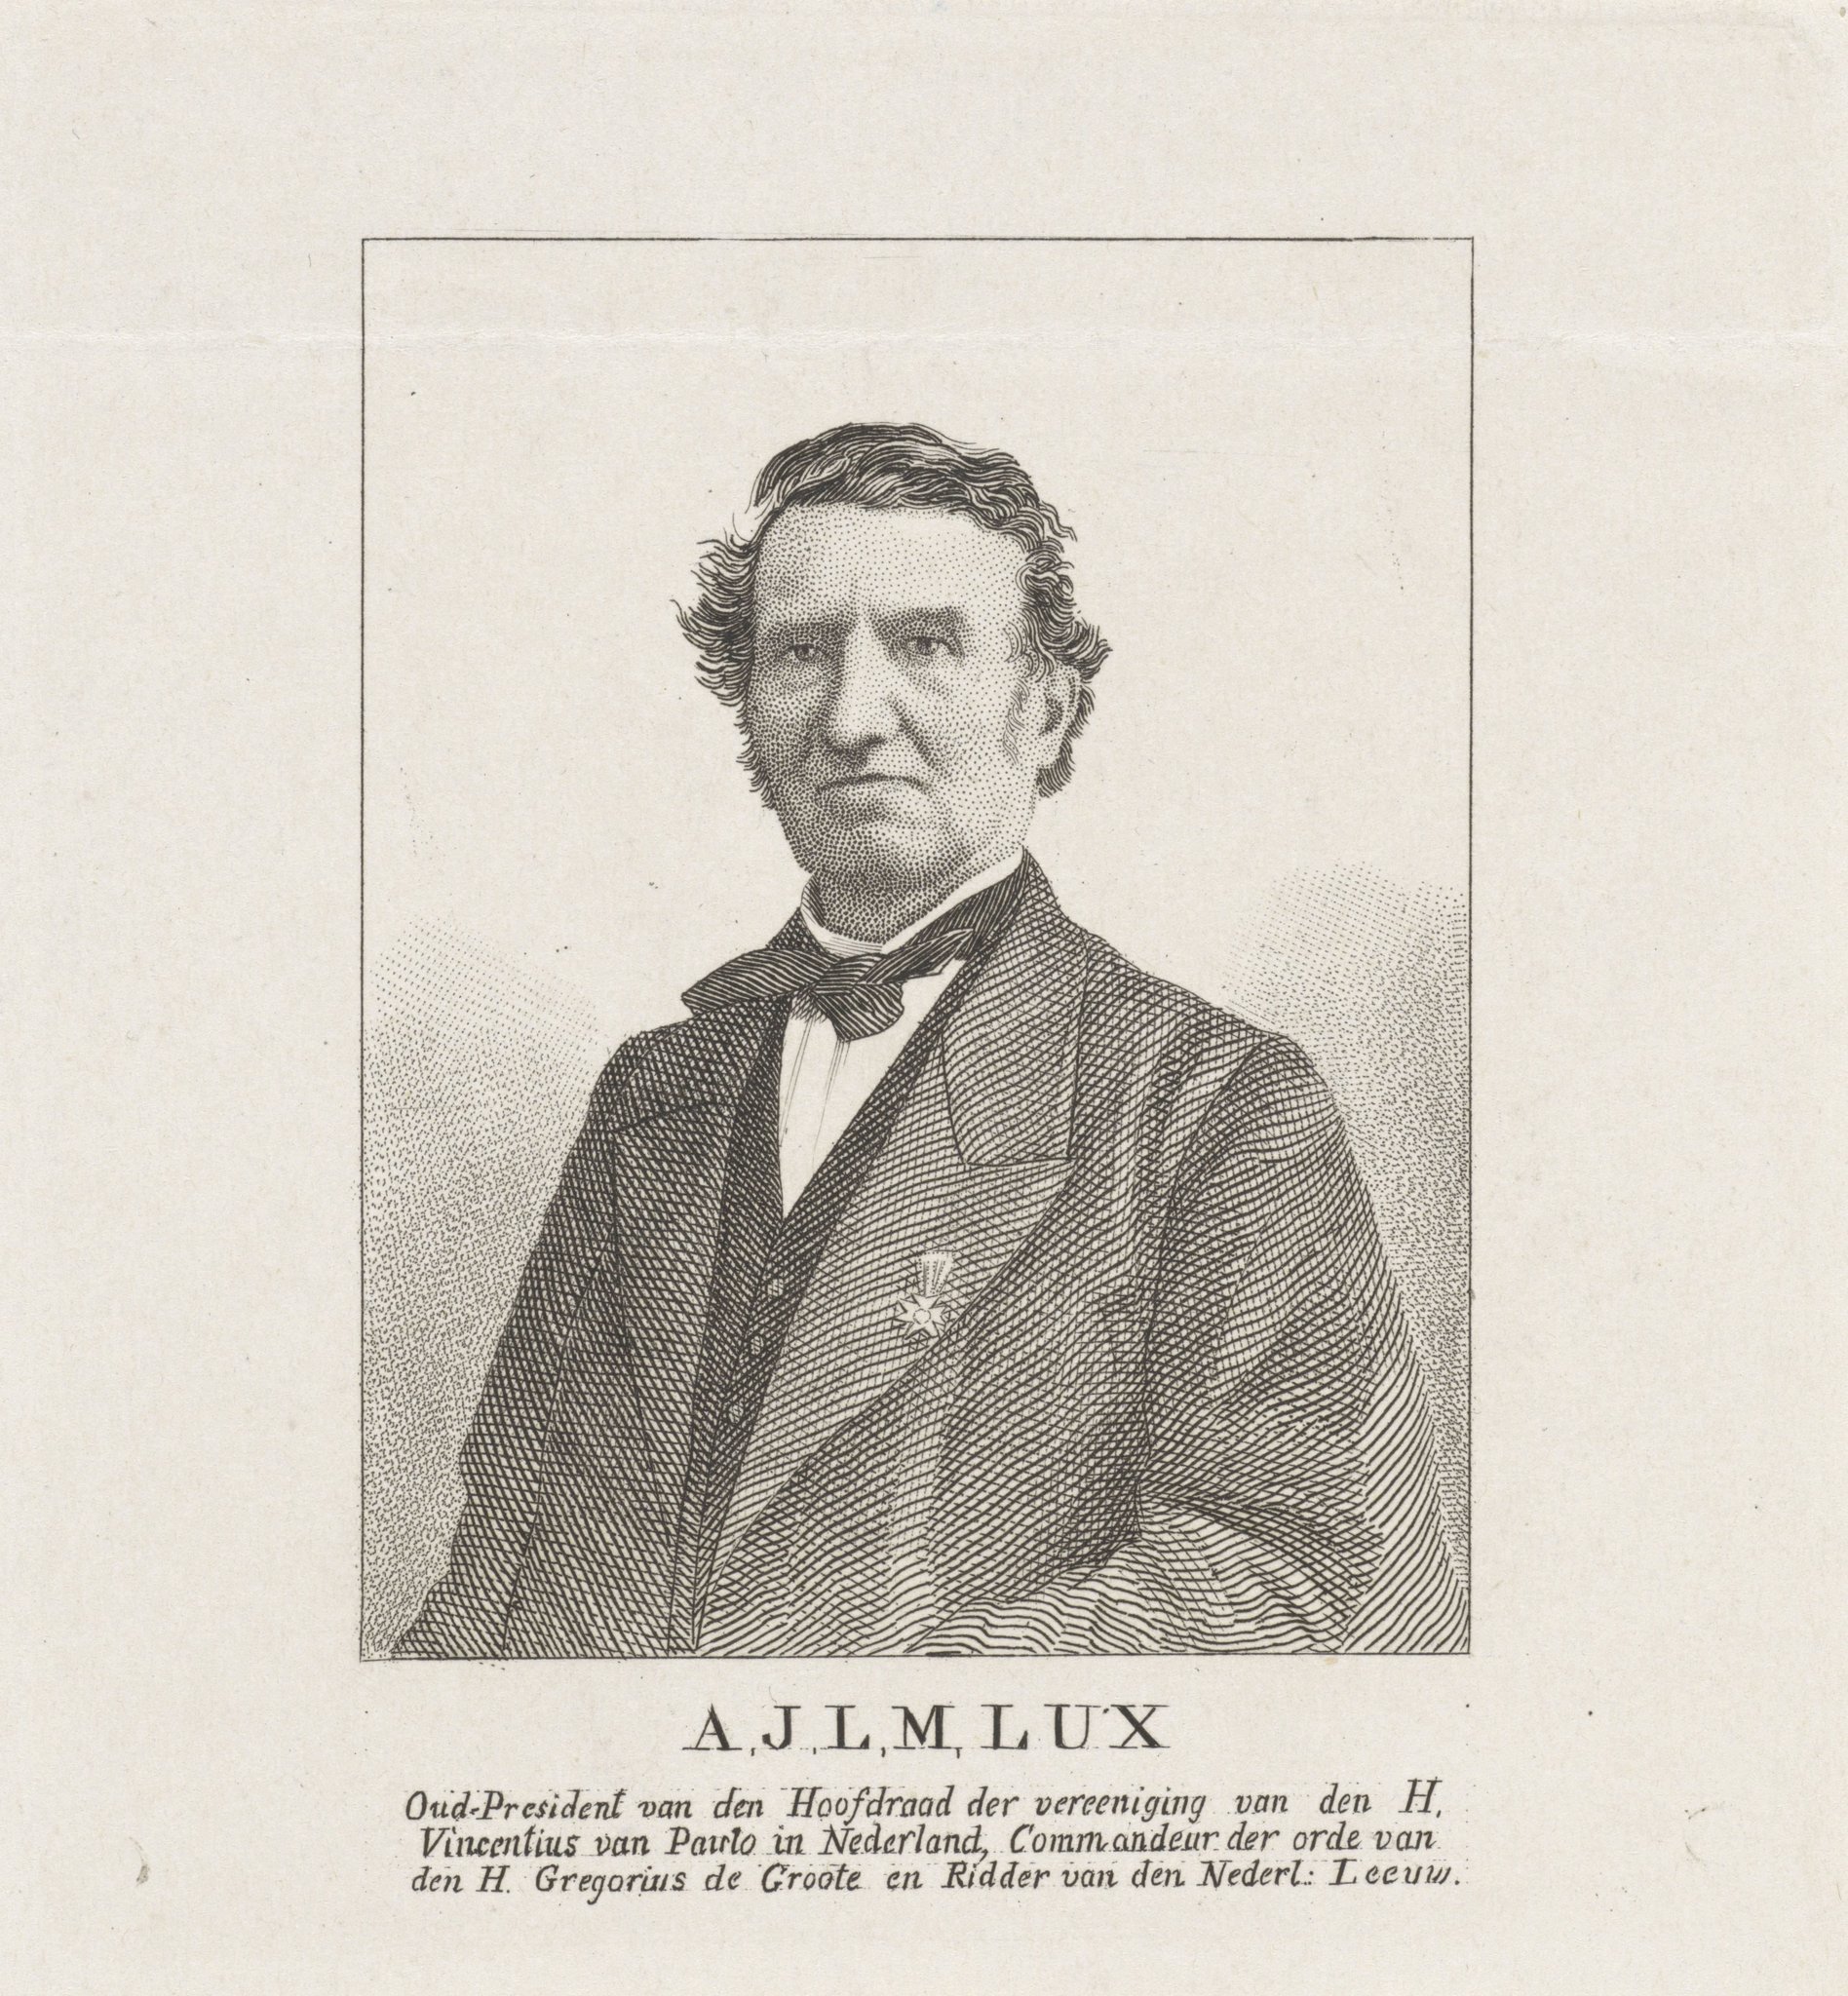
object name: print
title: Portret van A.J.L.M. Lux, oprichter van de Vincentiusvereniging in Nederland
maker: dirk jurriaan sluyter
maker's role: draughtsman, print maker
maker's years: 1811-1886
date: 1860-1886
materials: paper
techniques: engraving, etching, roulette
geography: amsterdam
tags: a.j.l.m. lux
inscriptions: collector's mark: Lugt 2228